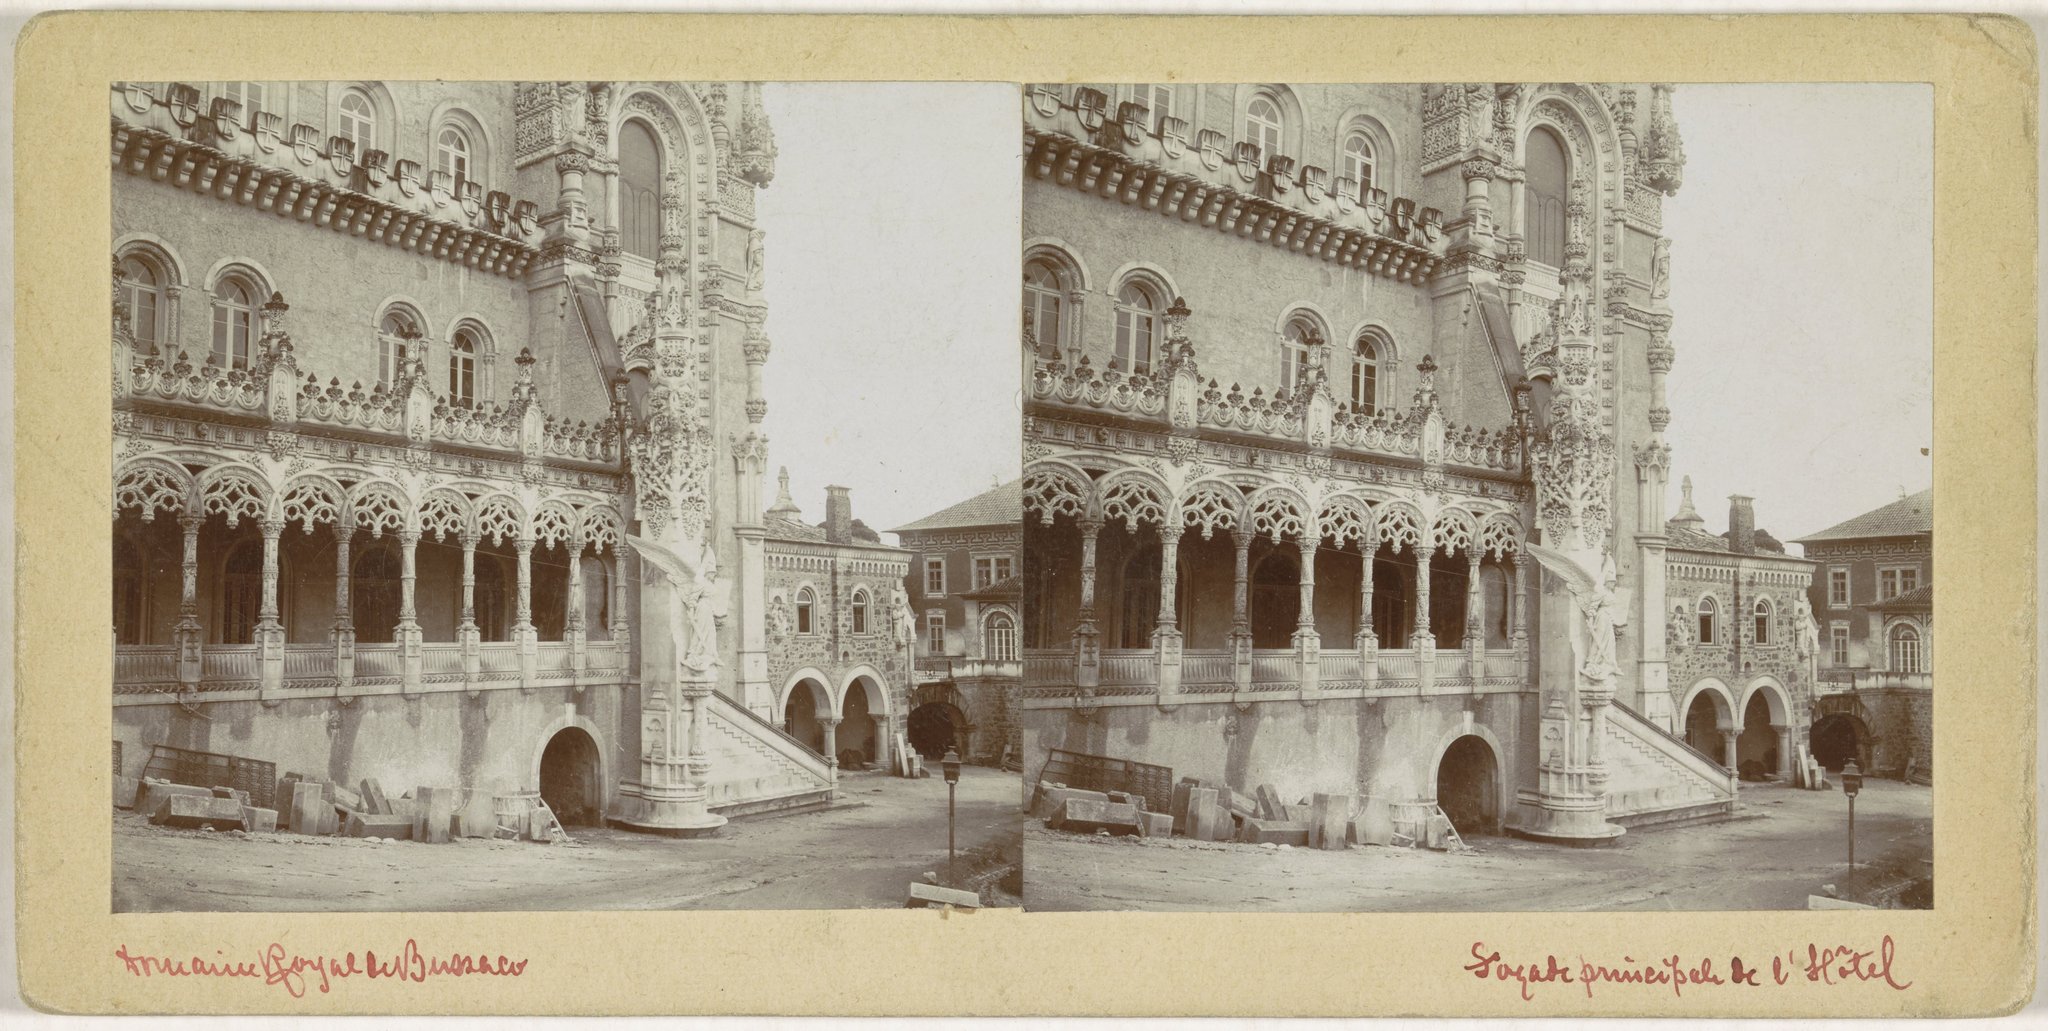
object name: stereograph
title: Gevel van het Palácio Hotel do Buçaco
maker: josé maria dos santos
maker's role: fotograaf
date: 1869-1900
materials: paper, cardboard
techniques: gelatin silver print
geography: palácio hotel do buçaco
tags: palace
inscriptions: inscription: ‘Photographia Conimbricense’